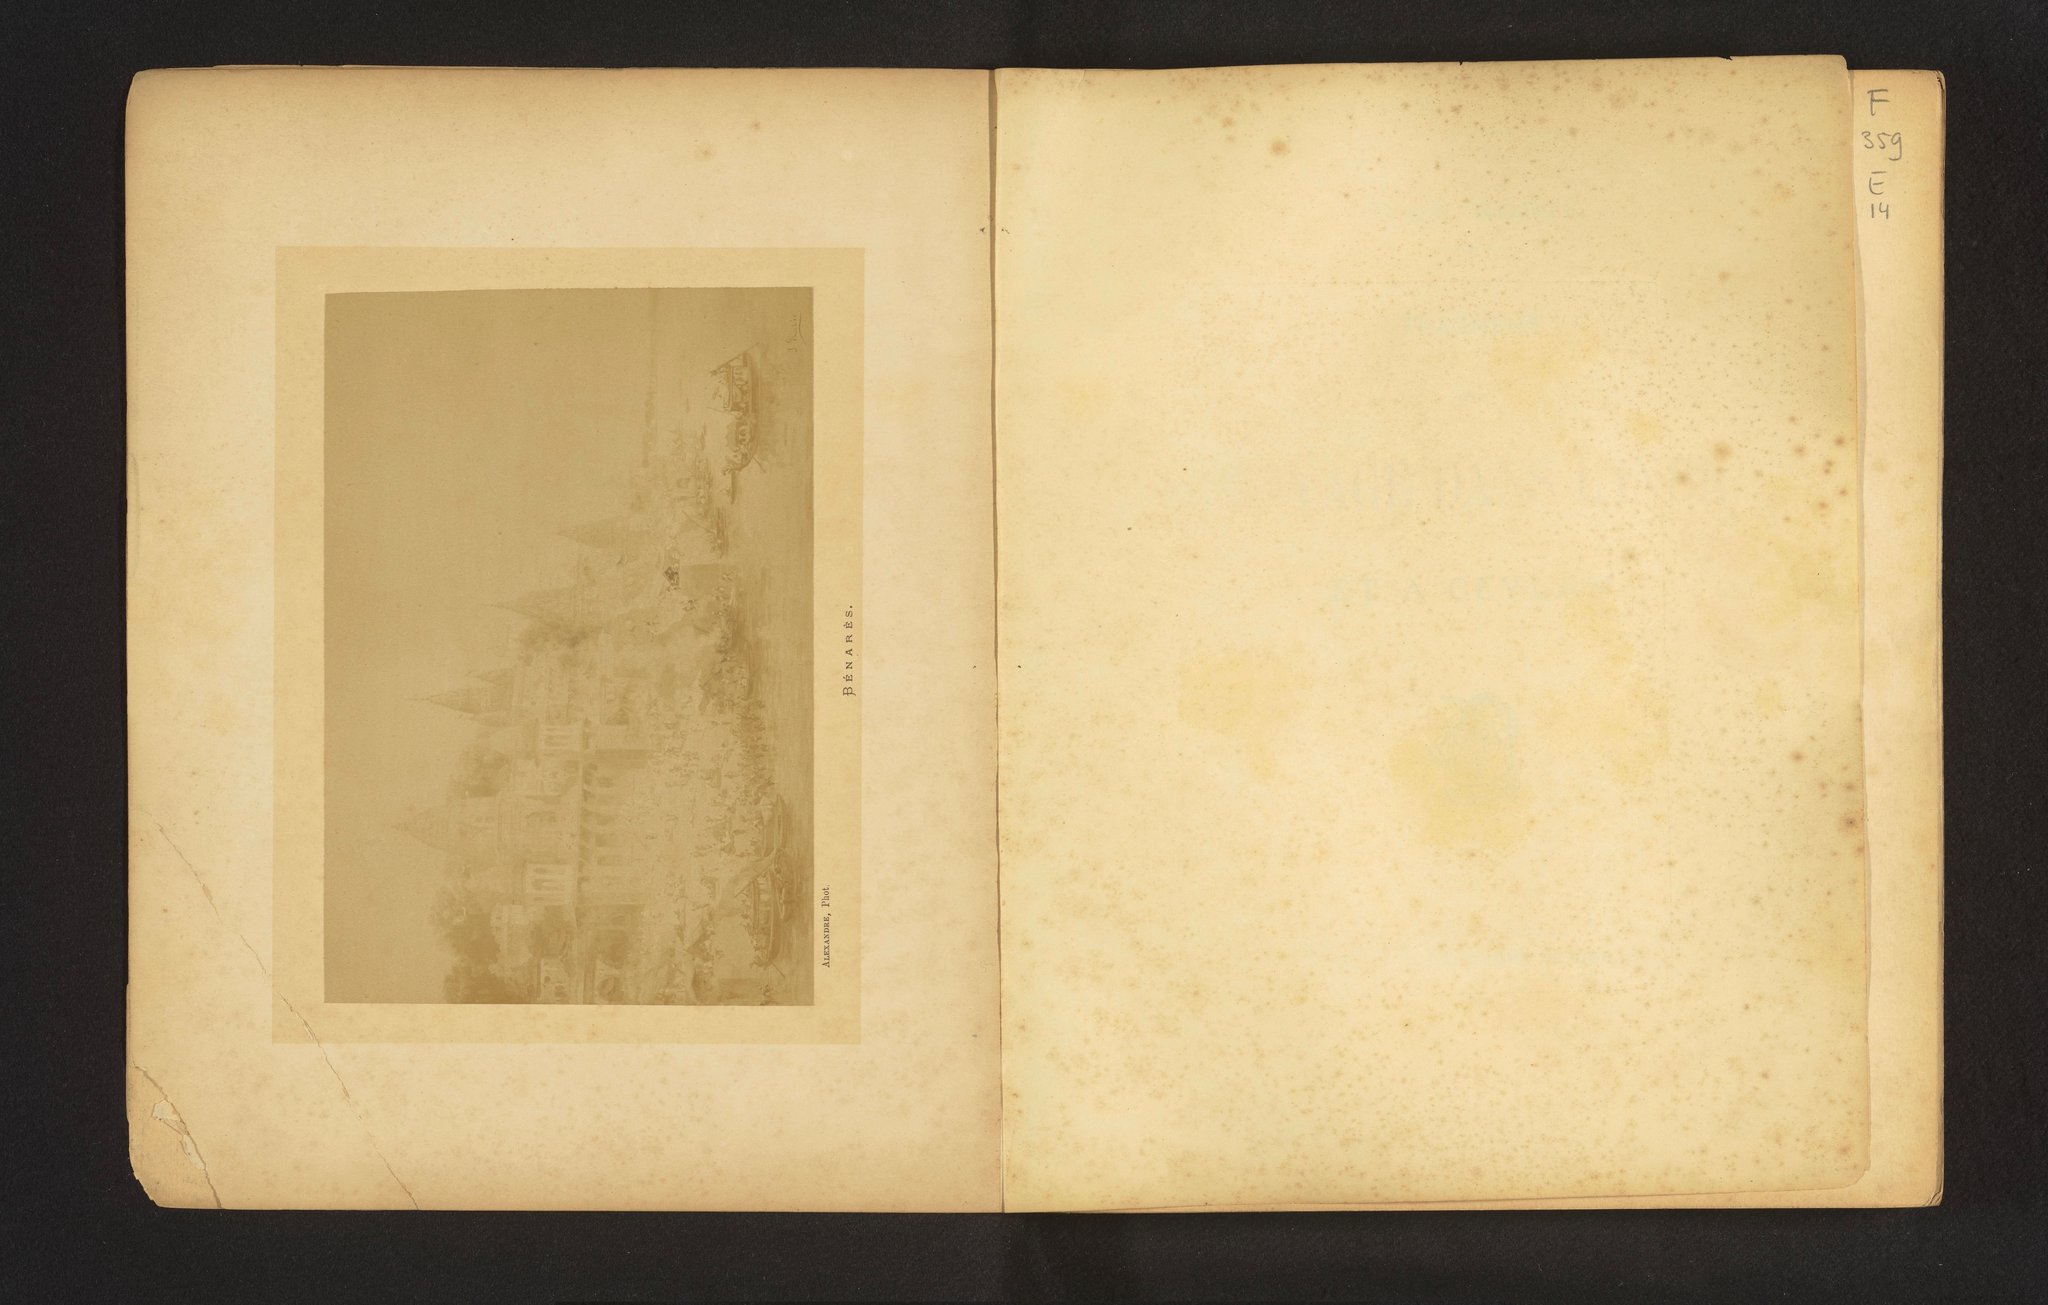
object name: page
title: Fotoreproductie van Bénarès door Jean Baptiste Robie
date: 1880-1885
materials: photographic support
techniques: albumen print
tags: prospect of city, town panorama, silhouette of city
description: Foto tegenover titelpagina, achter omslag.